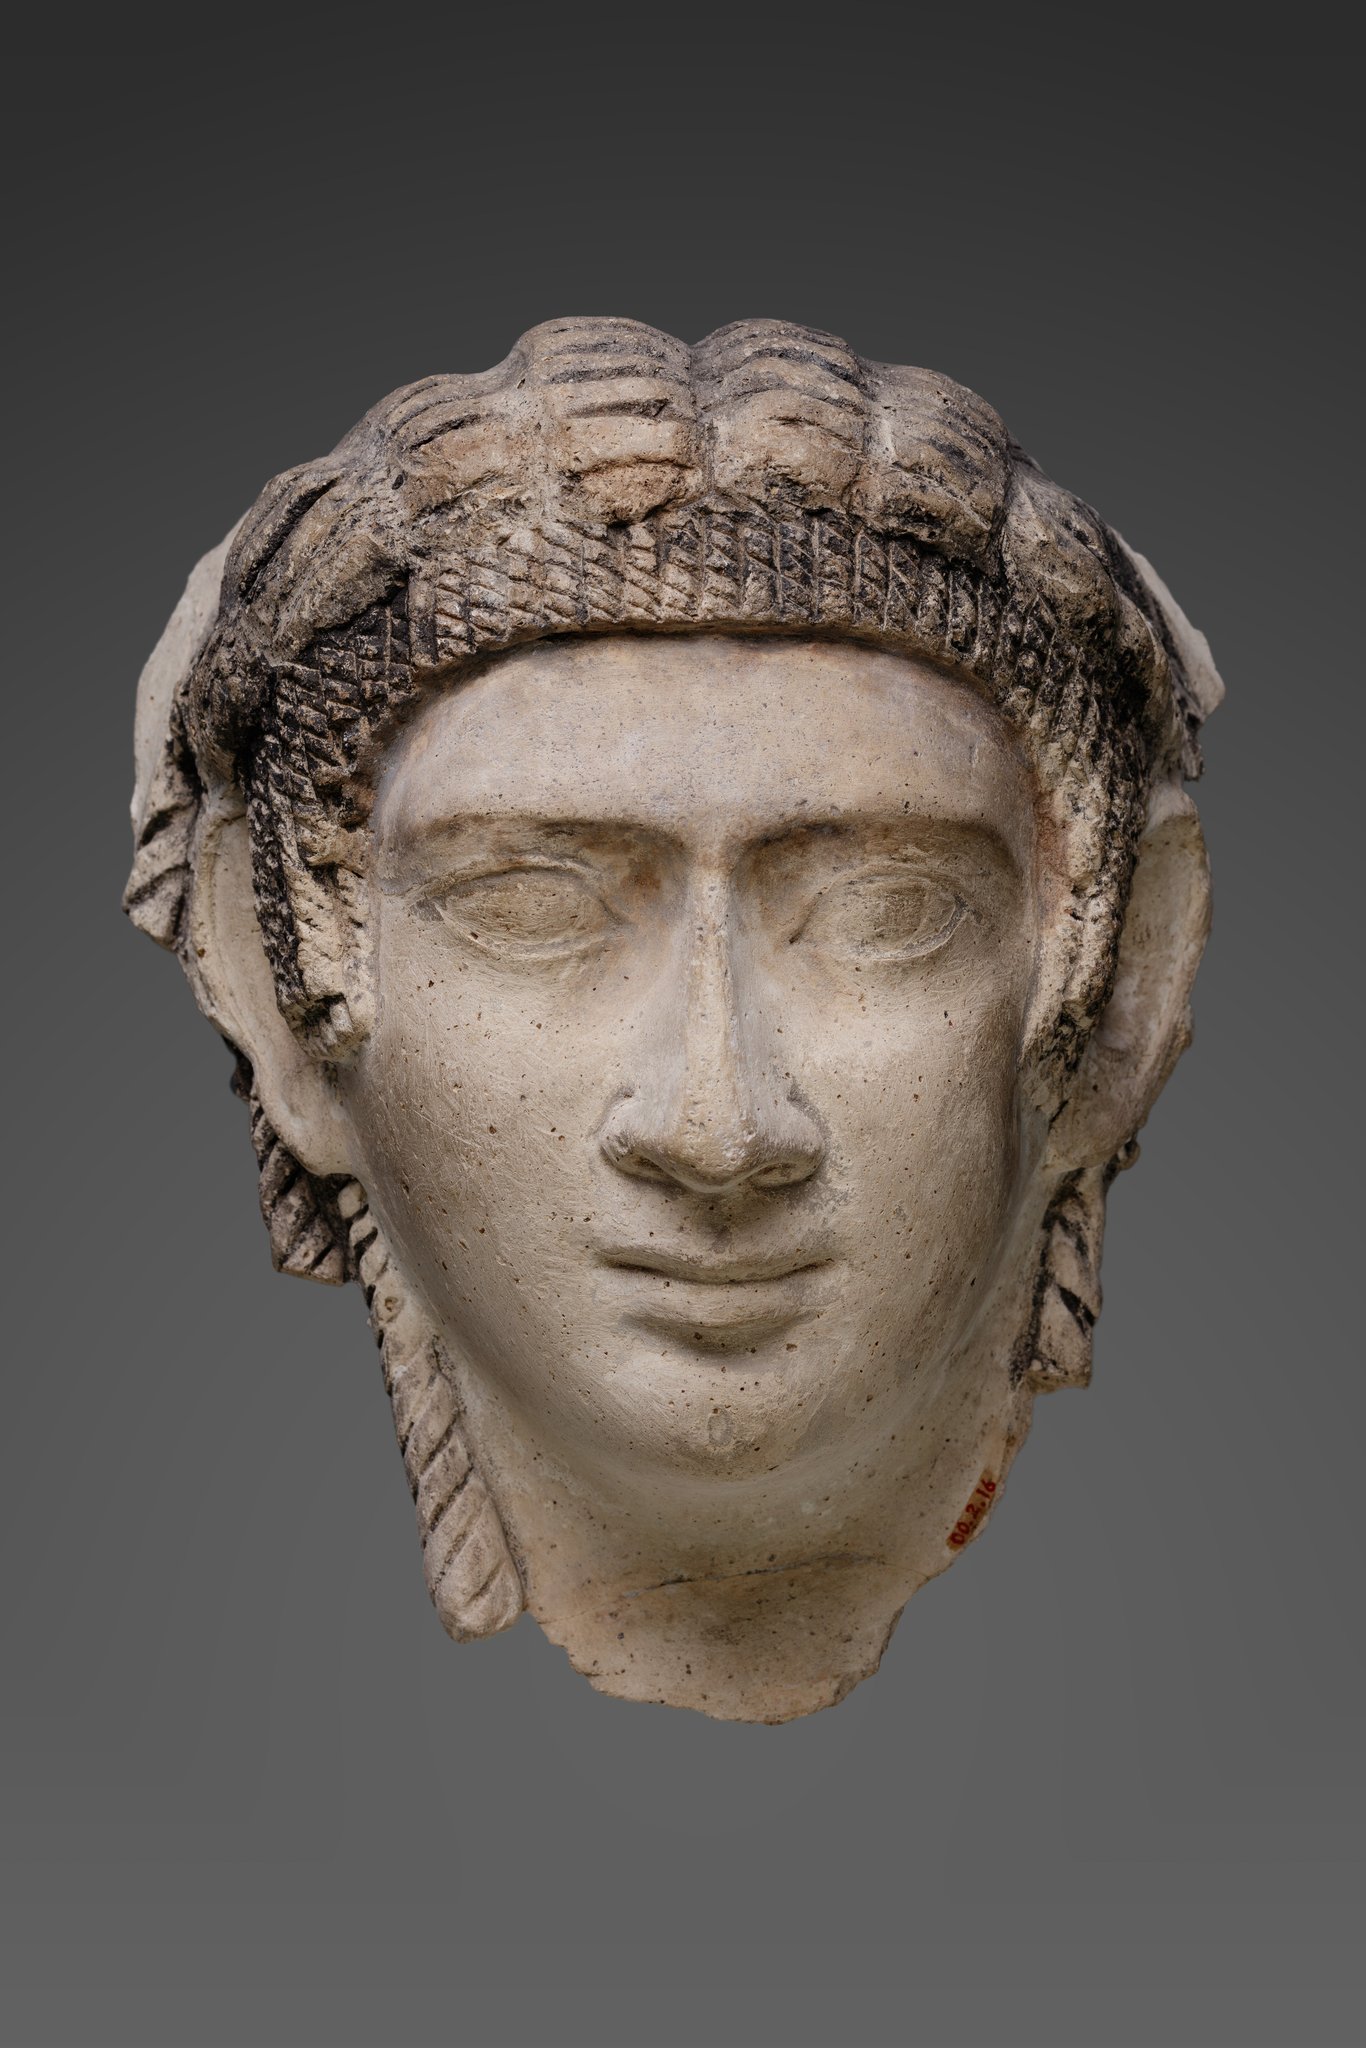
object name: mask, woman, corkscrew lock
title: Mask of a woman with corkscrew locks and bang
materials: paint, plaster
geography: egypt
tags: women